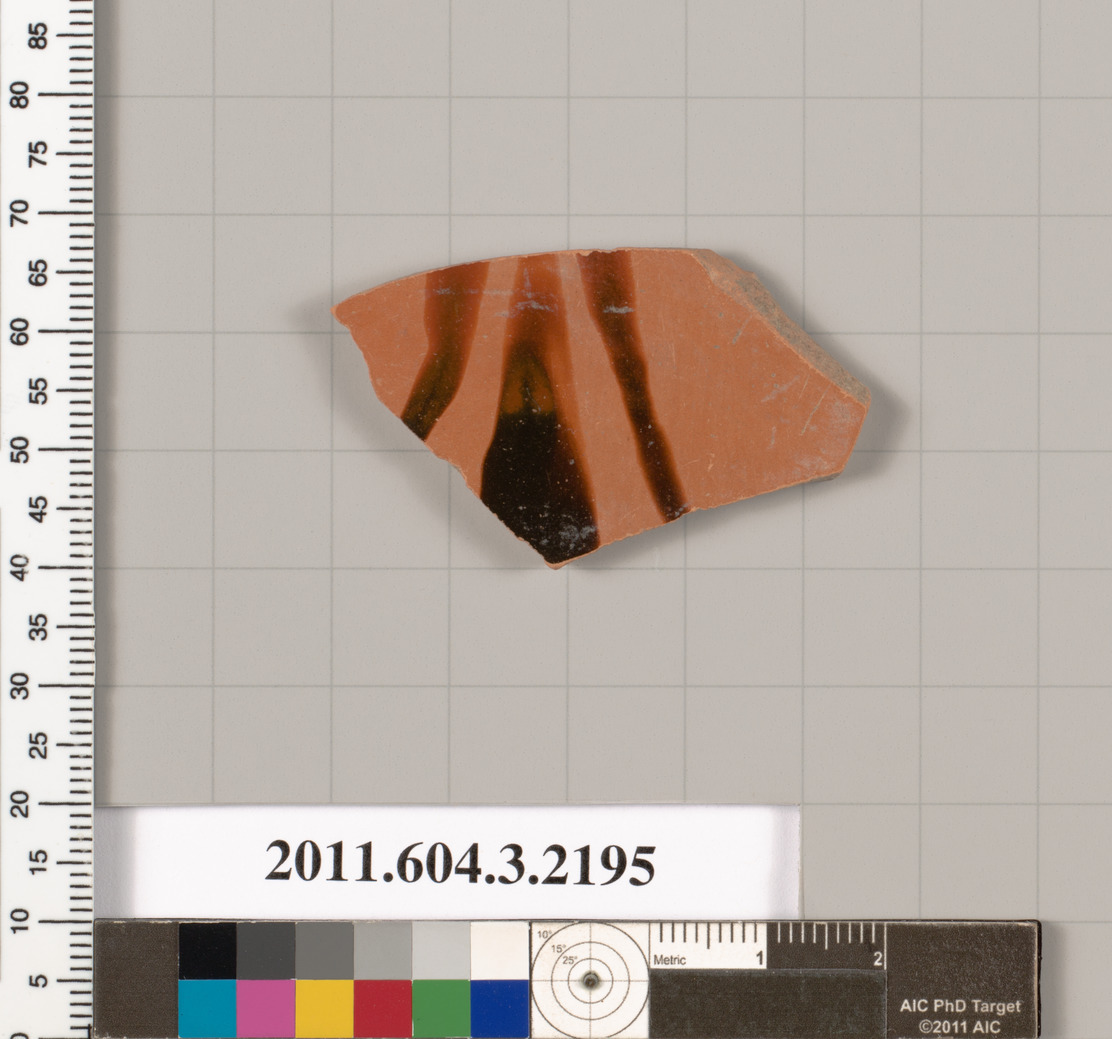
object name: kylix fragment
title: Terracotta fragment of a kylix (drinking cup)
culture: greek, attic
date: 534-468 BCE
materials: terracotta